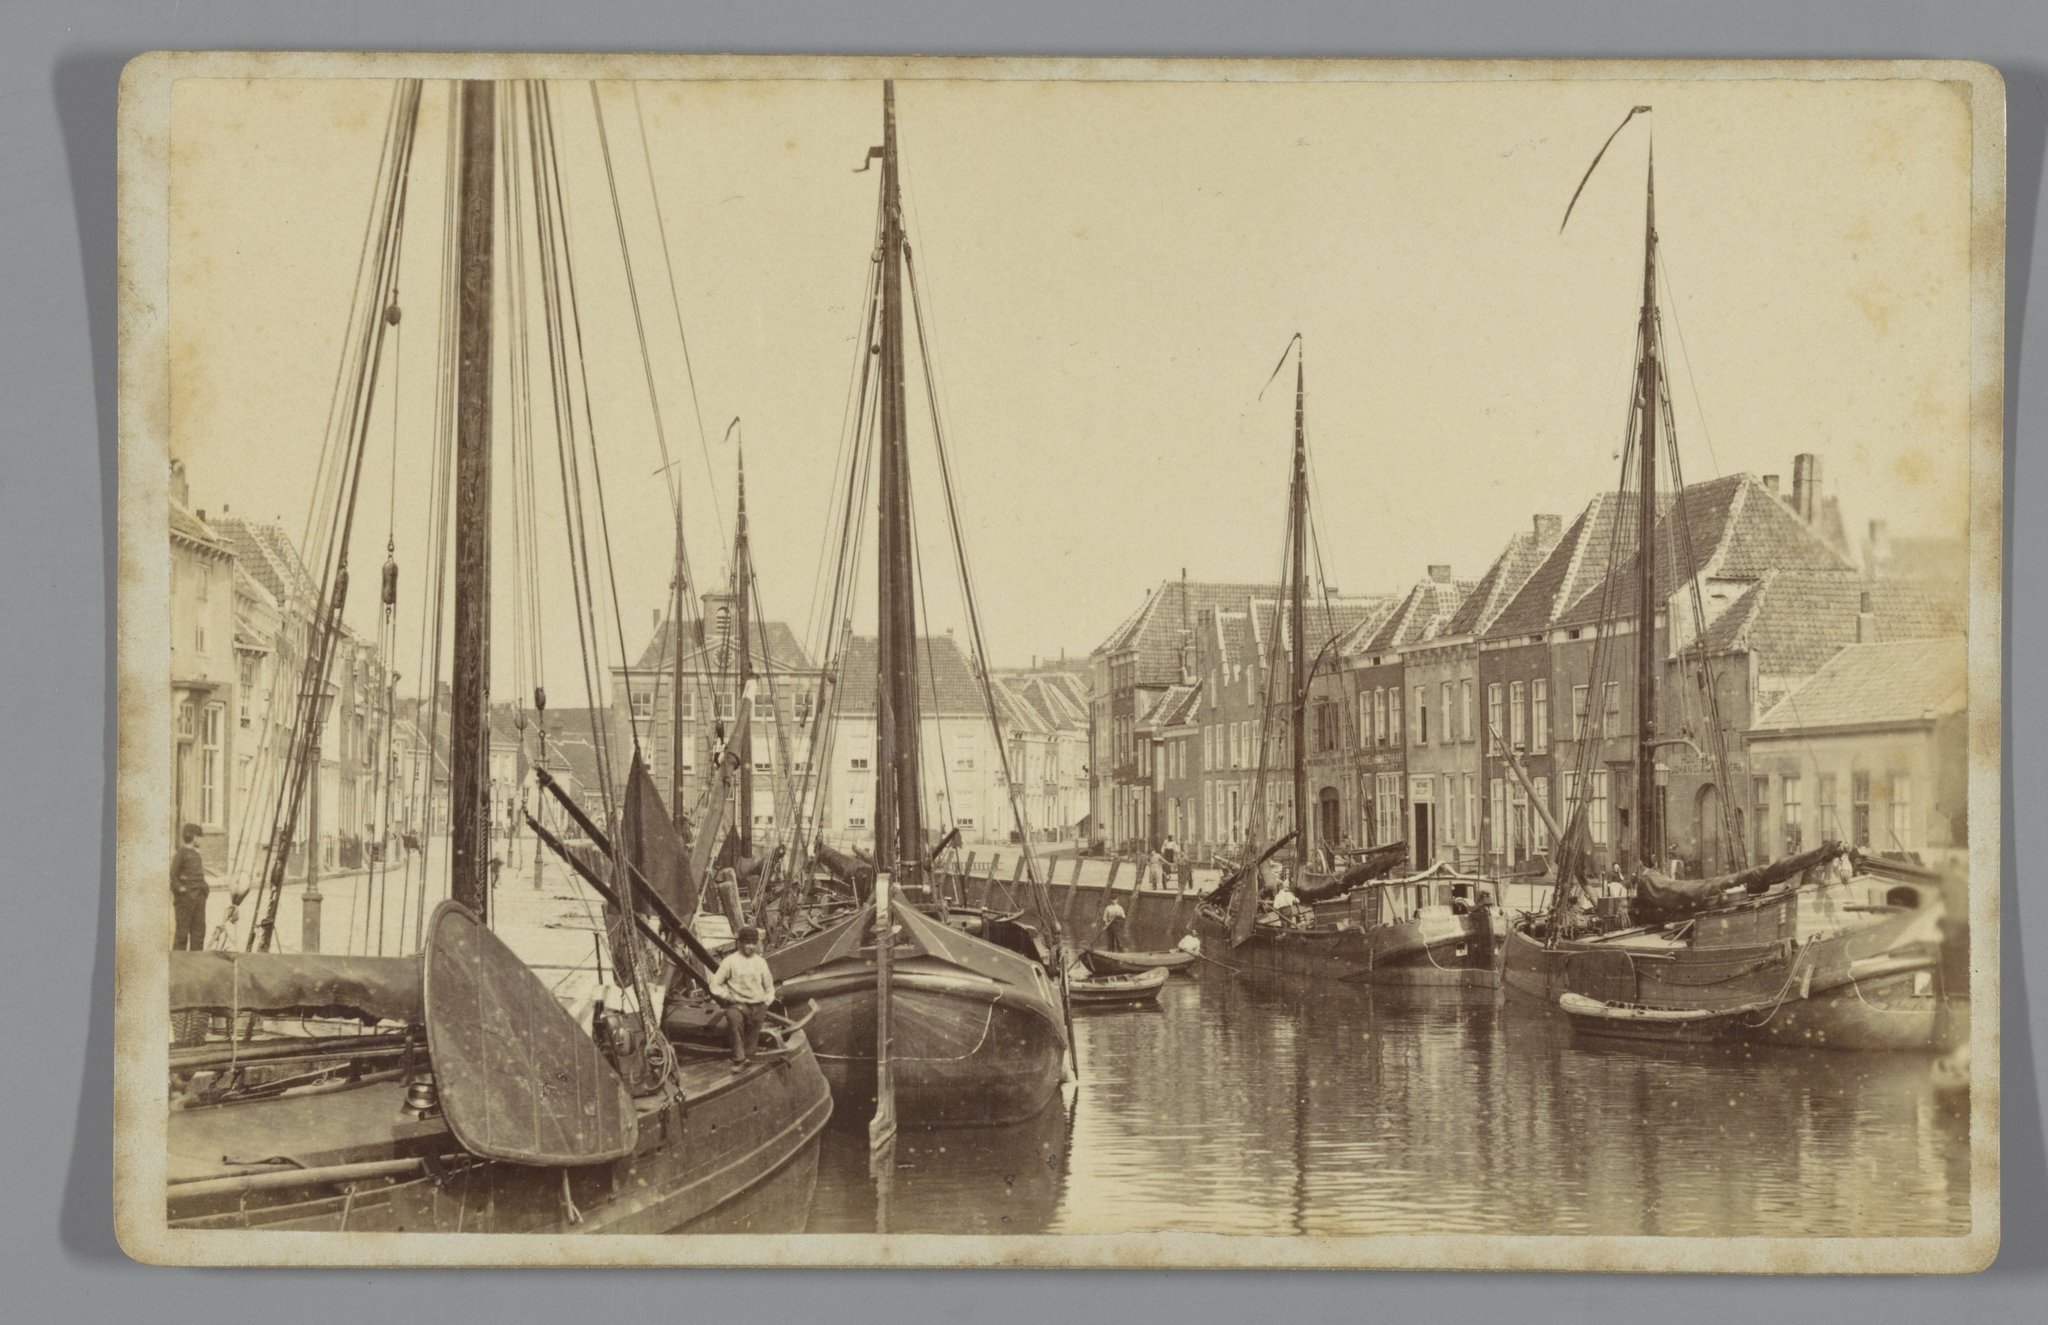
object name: cabinet photograph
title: Schepen in de Oude Binnenhaven van Bergen op Zoom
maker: jannis jacobus van melle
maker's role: fotograaf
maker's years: 1829-1911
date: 1880-1900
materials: cardboard, paper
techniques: albumen print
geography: bergen op zoom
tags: harbour, bergen op zoom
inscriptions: collector's mark: ‘Vosmaer’, inscription: ‘Cabinet-Portrait/ J.J. van Melle/ Photographe/ Bergen op Zoom/ Rijkebuurtstraat’